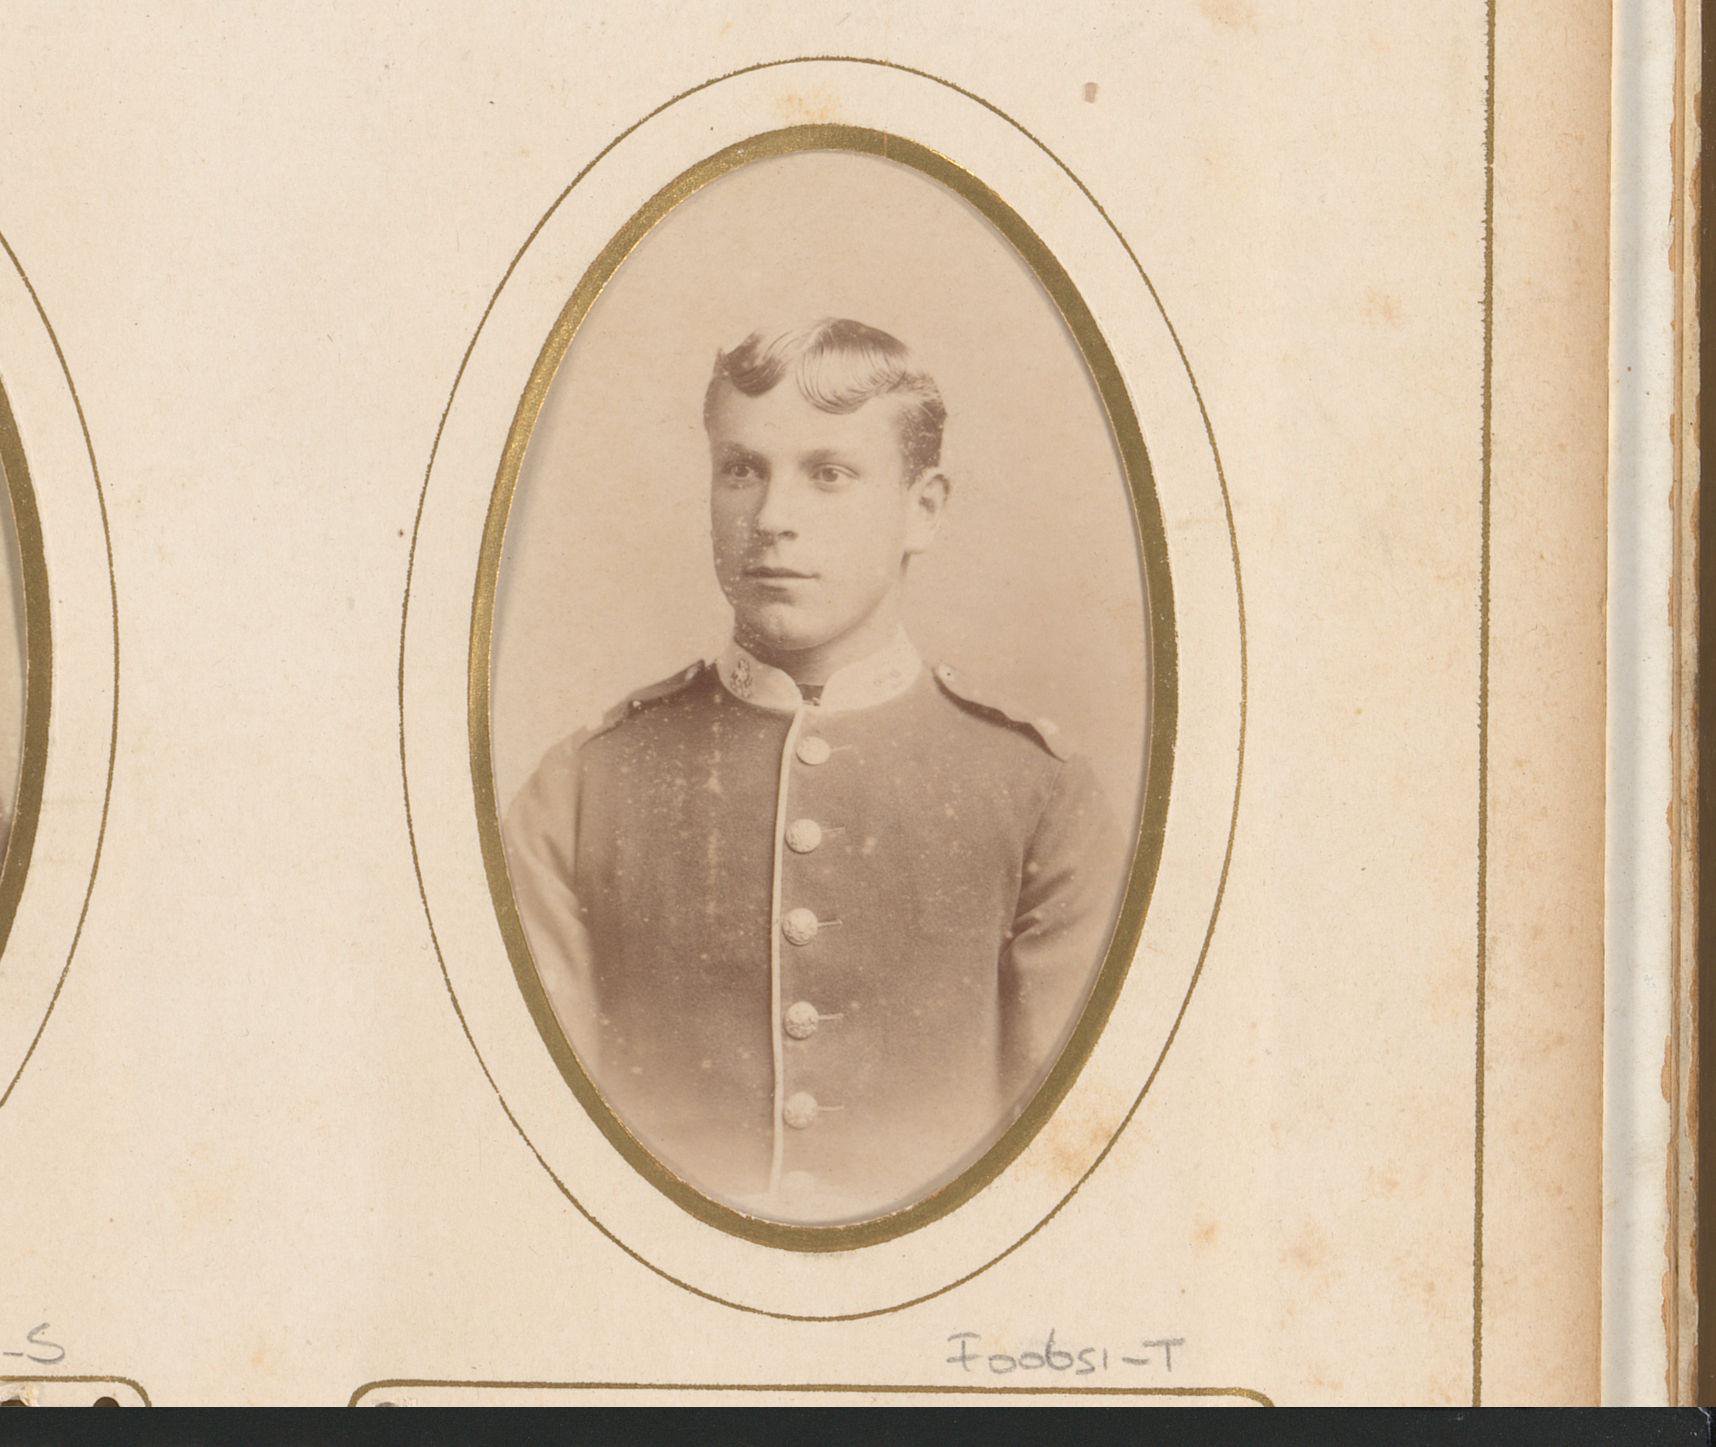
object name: carte de visite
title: Portret van Jesse May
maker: george west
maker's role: fotograaf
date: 1883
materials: cardboard, photographic support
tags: adult man, historical persons, seaman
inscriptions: annotation: ‘[...] Jesse May/ July 27'83’, inscription: ‘Eagle House 97 High Street Gosport (...)’